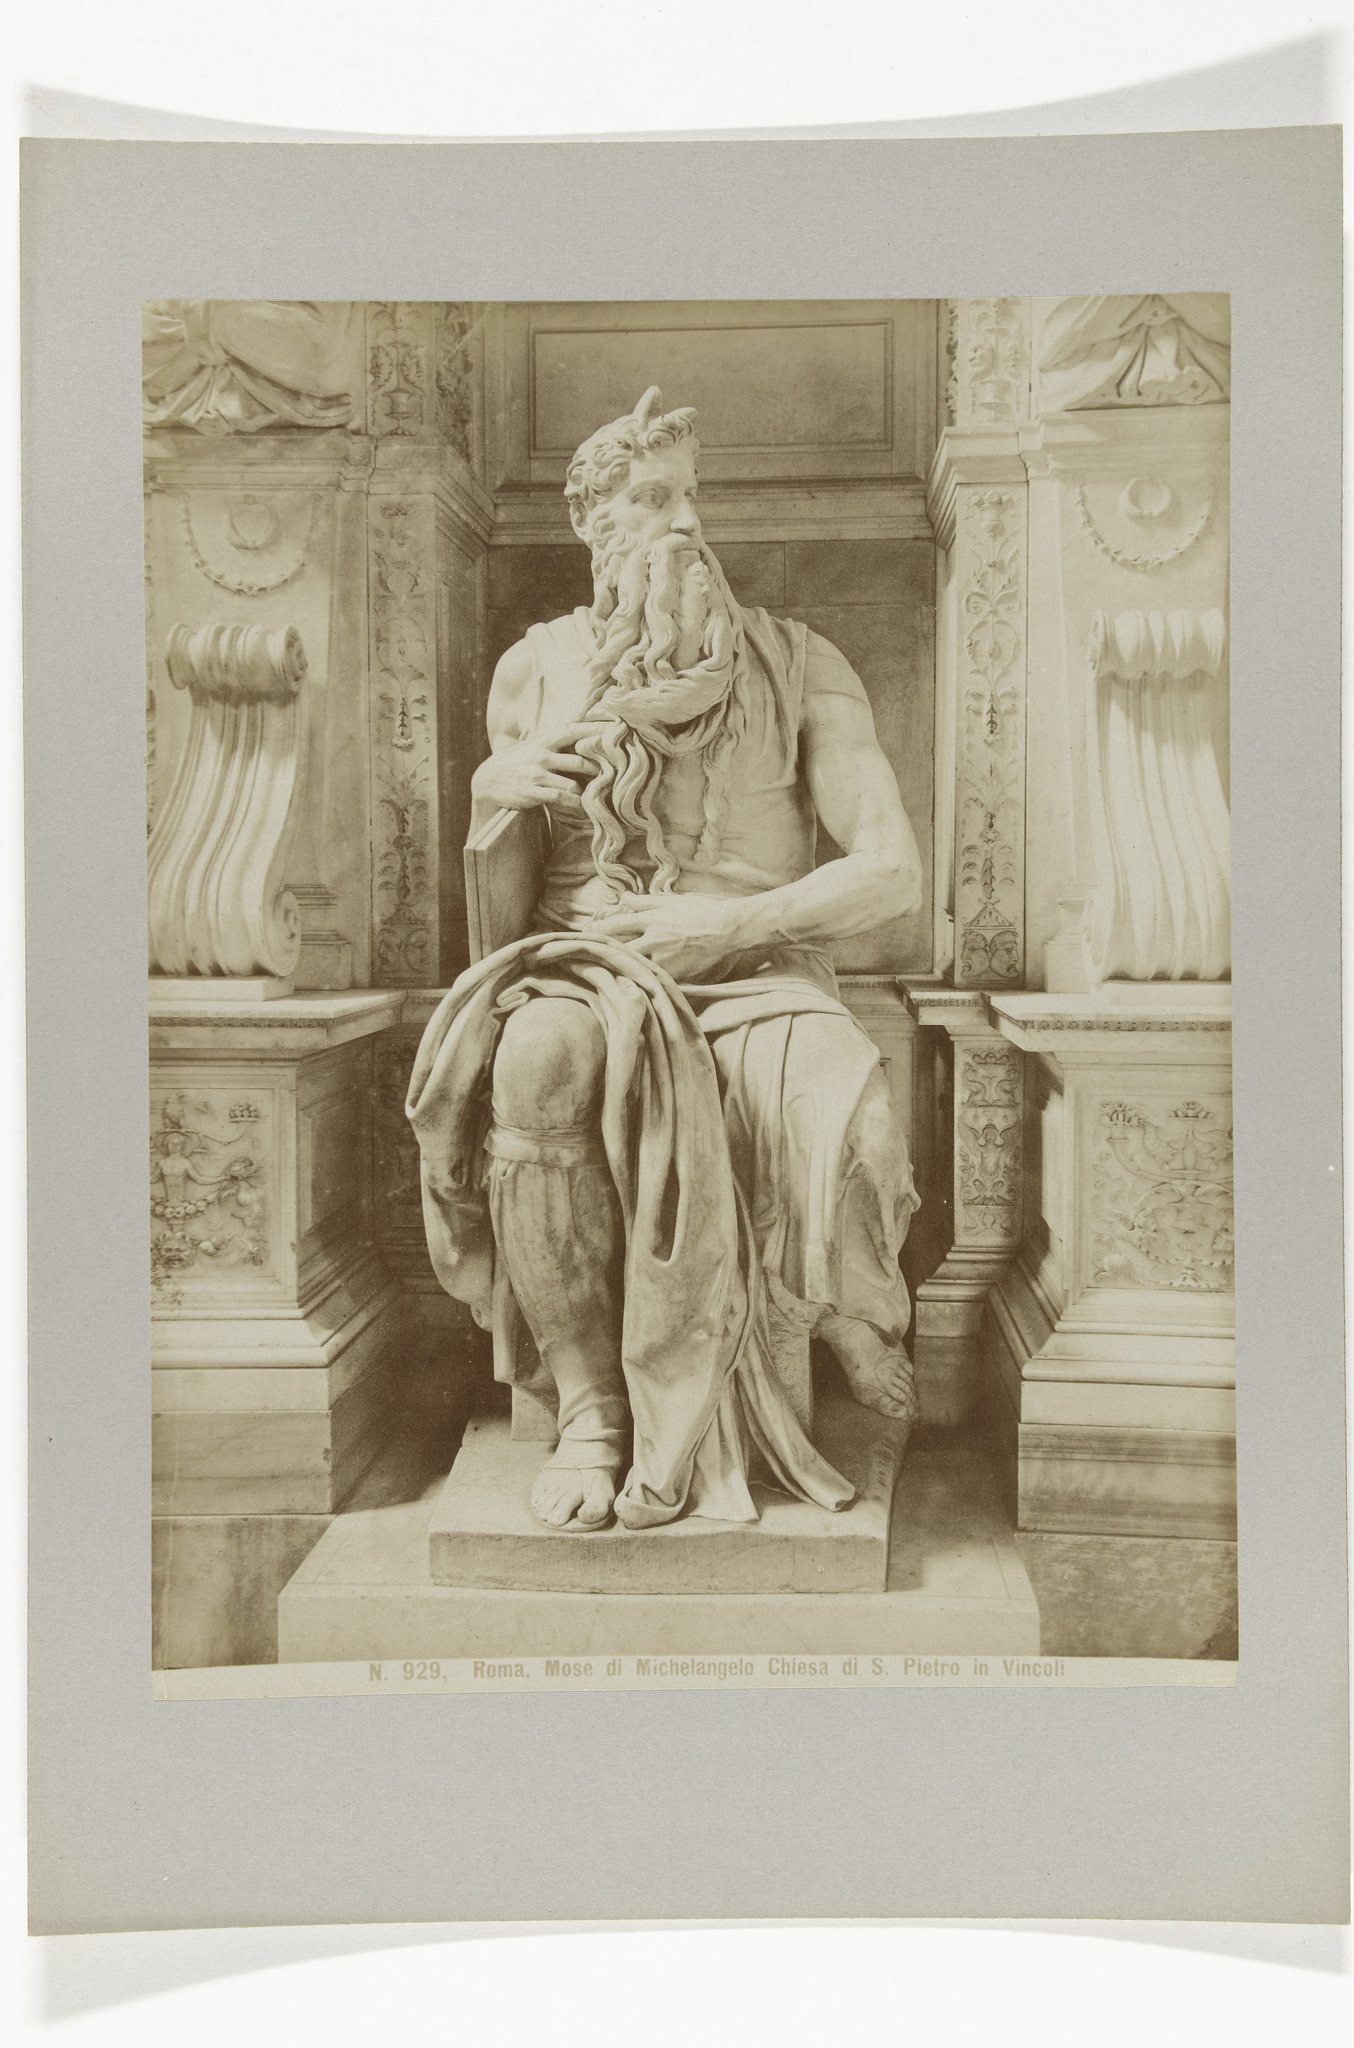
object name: photograph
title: Beeldhouwwerk van Mozes in de kerk San Pietro in Vincoli, Rome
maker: Anonymous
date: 1880-1904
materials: cardboard, paper, photographic support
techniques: albumen print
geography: rome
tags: san pietro in vincoli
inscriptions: number: ‘10.’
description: Beeldhouwwerk gemaakt door Michelangelo .